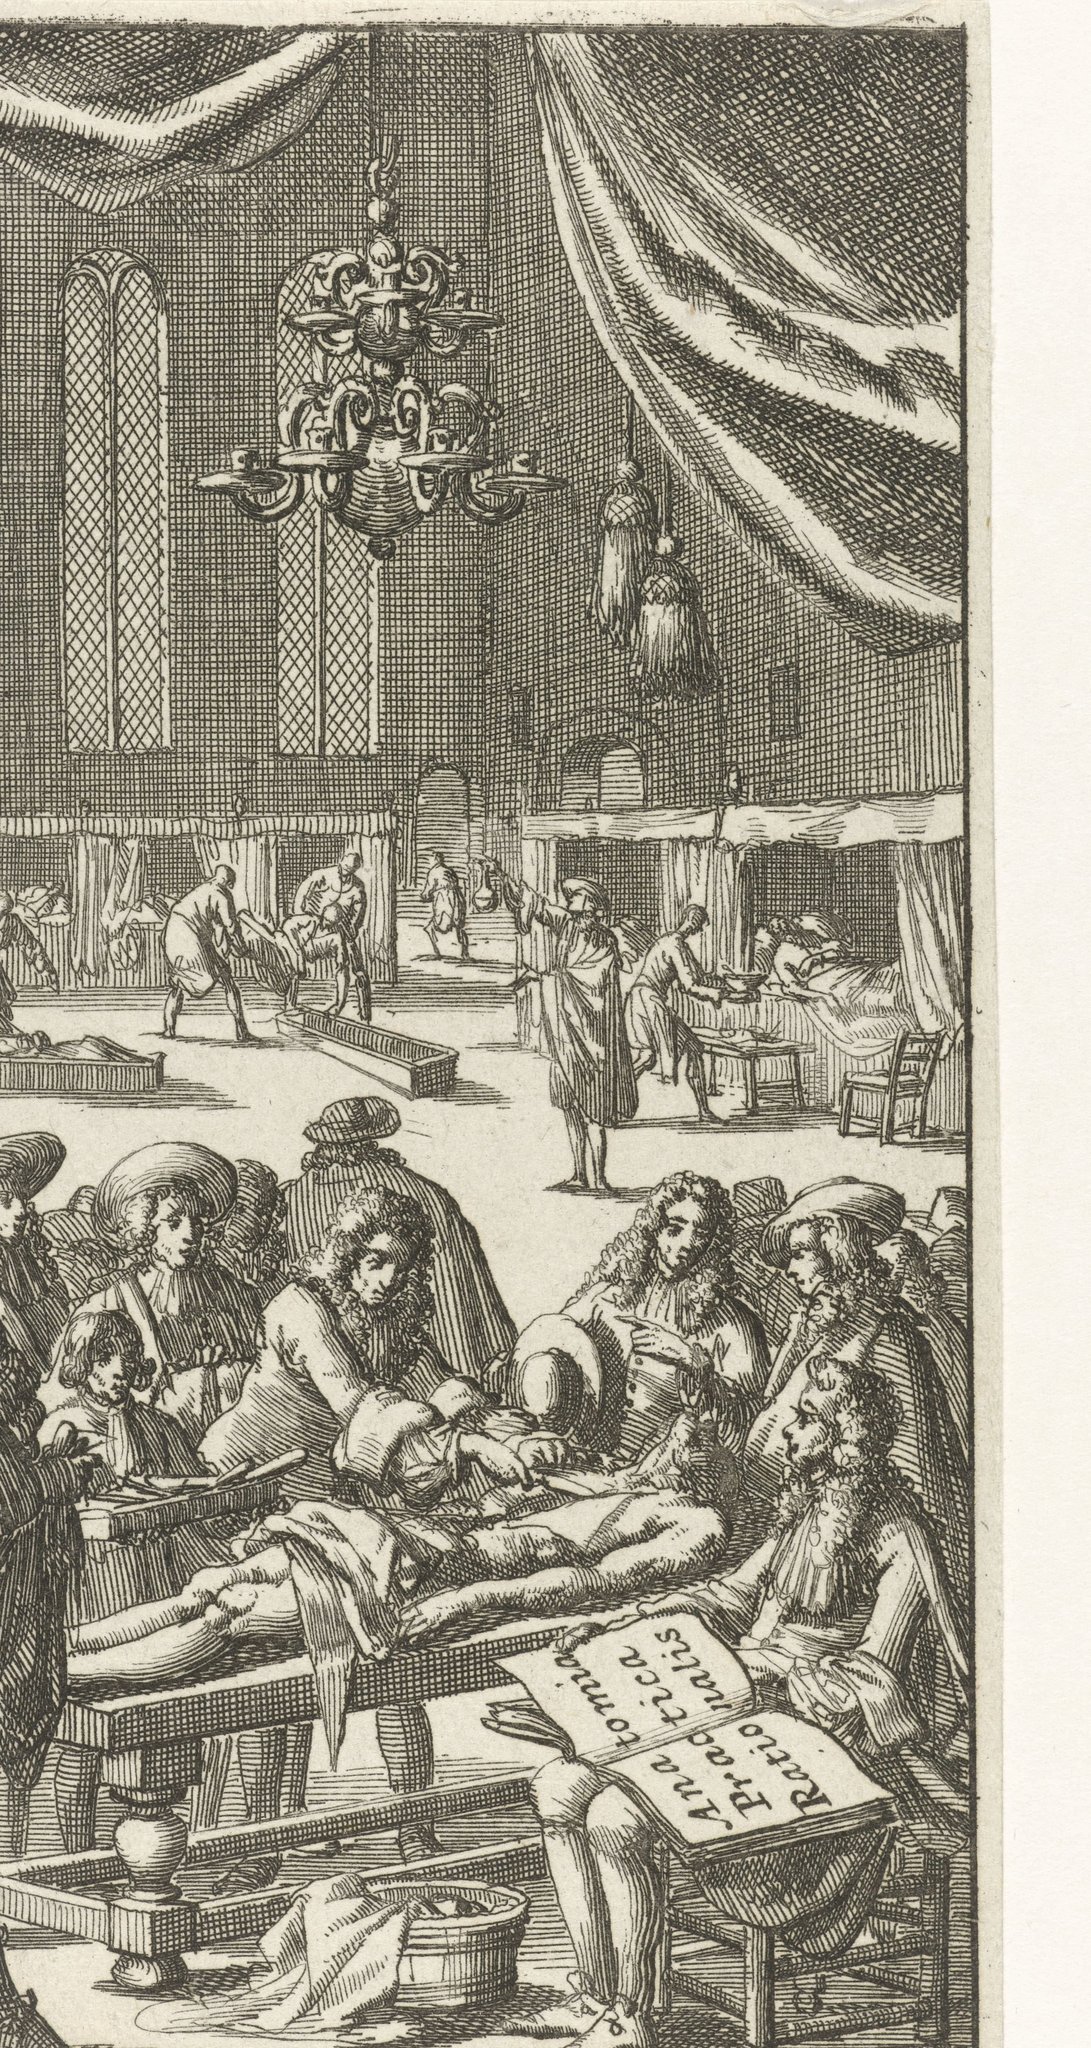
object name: print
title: Titelpagina voor: Blankaart, Steven. Anatomia practica rationalis, sive Rariorum cadaverum morbis denatorum anatomica inspectio. Amsterdam: Cornelis Blankaart, 1688.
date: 1688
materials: paper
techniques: etching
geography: amsterdam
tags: hospital, anatomy lesson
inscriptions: collector's mark: Lugt 2228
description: Titelpagina voor: Blankaart, Steven. Anatomia practica rationalis, sive Rariorum cadaverum morbis denatorum anatomica inspectio. Amsterdam: Cornelis Blankaart, 1688.